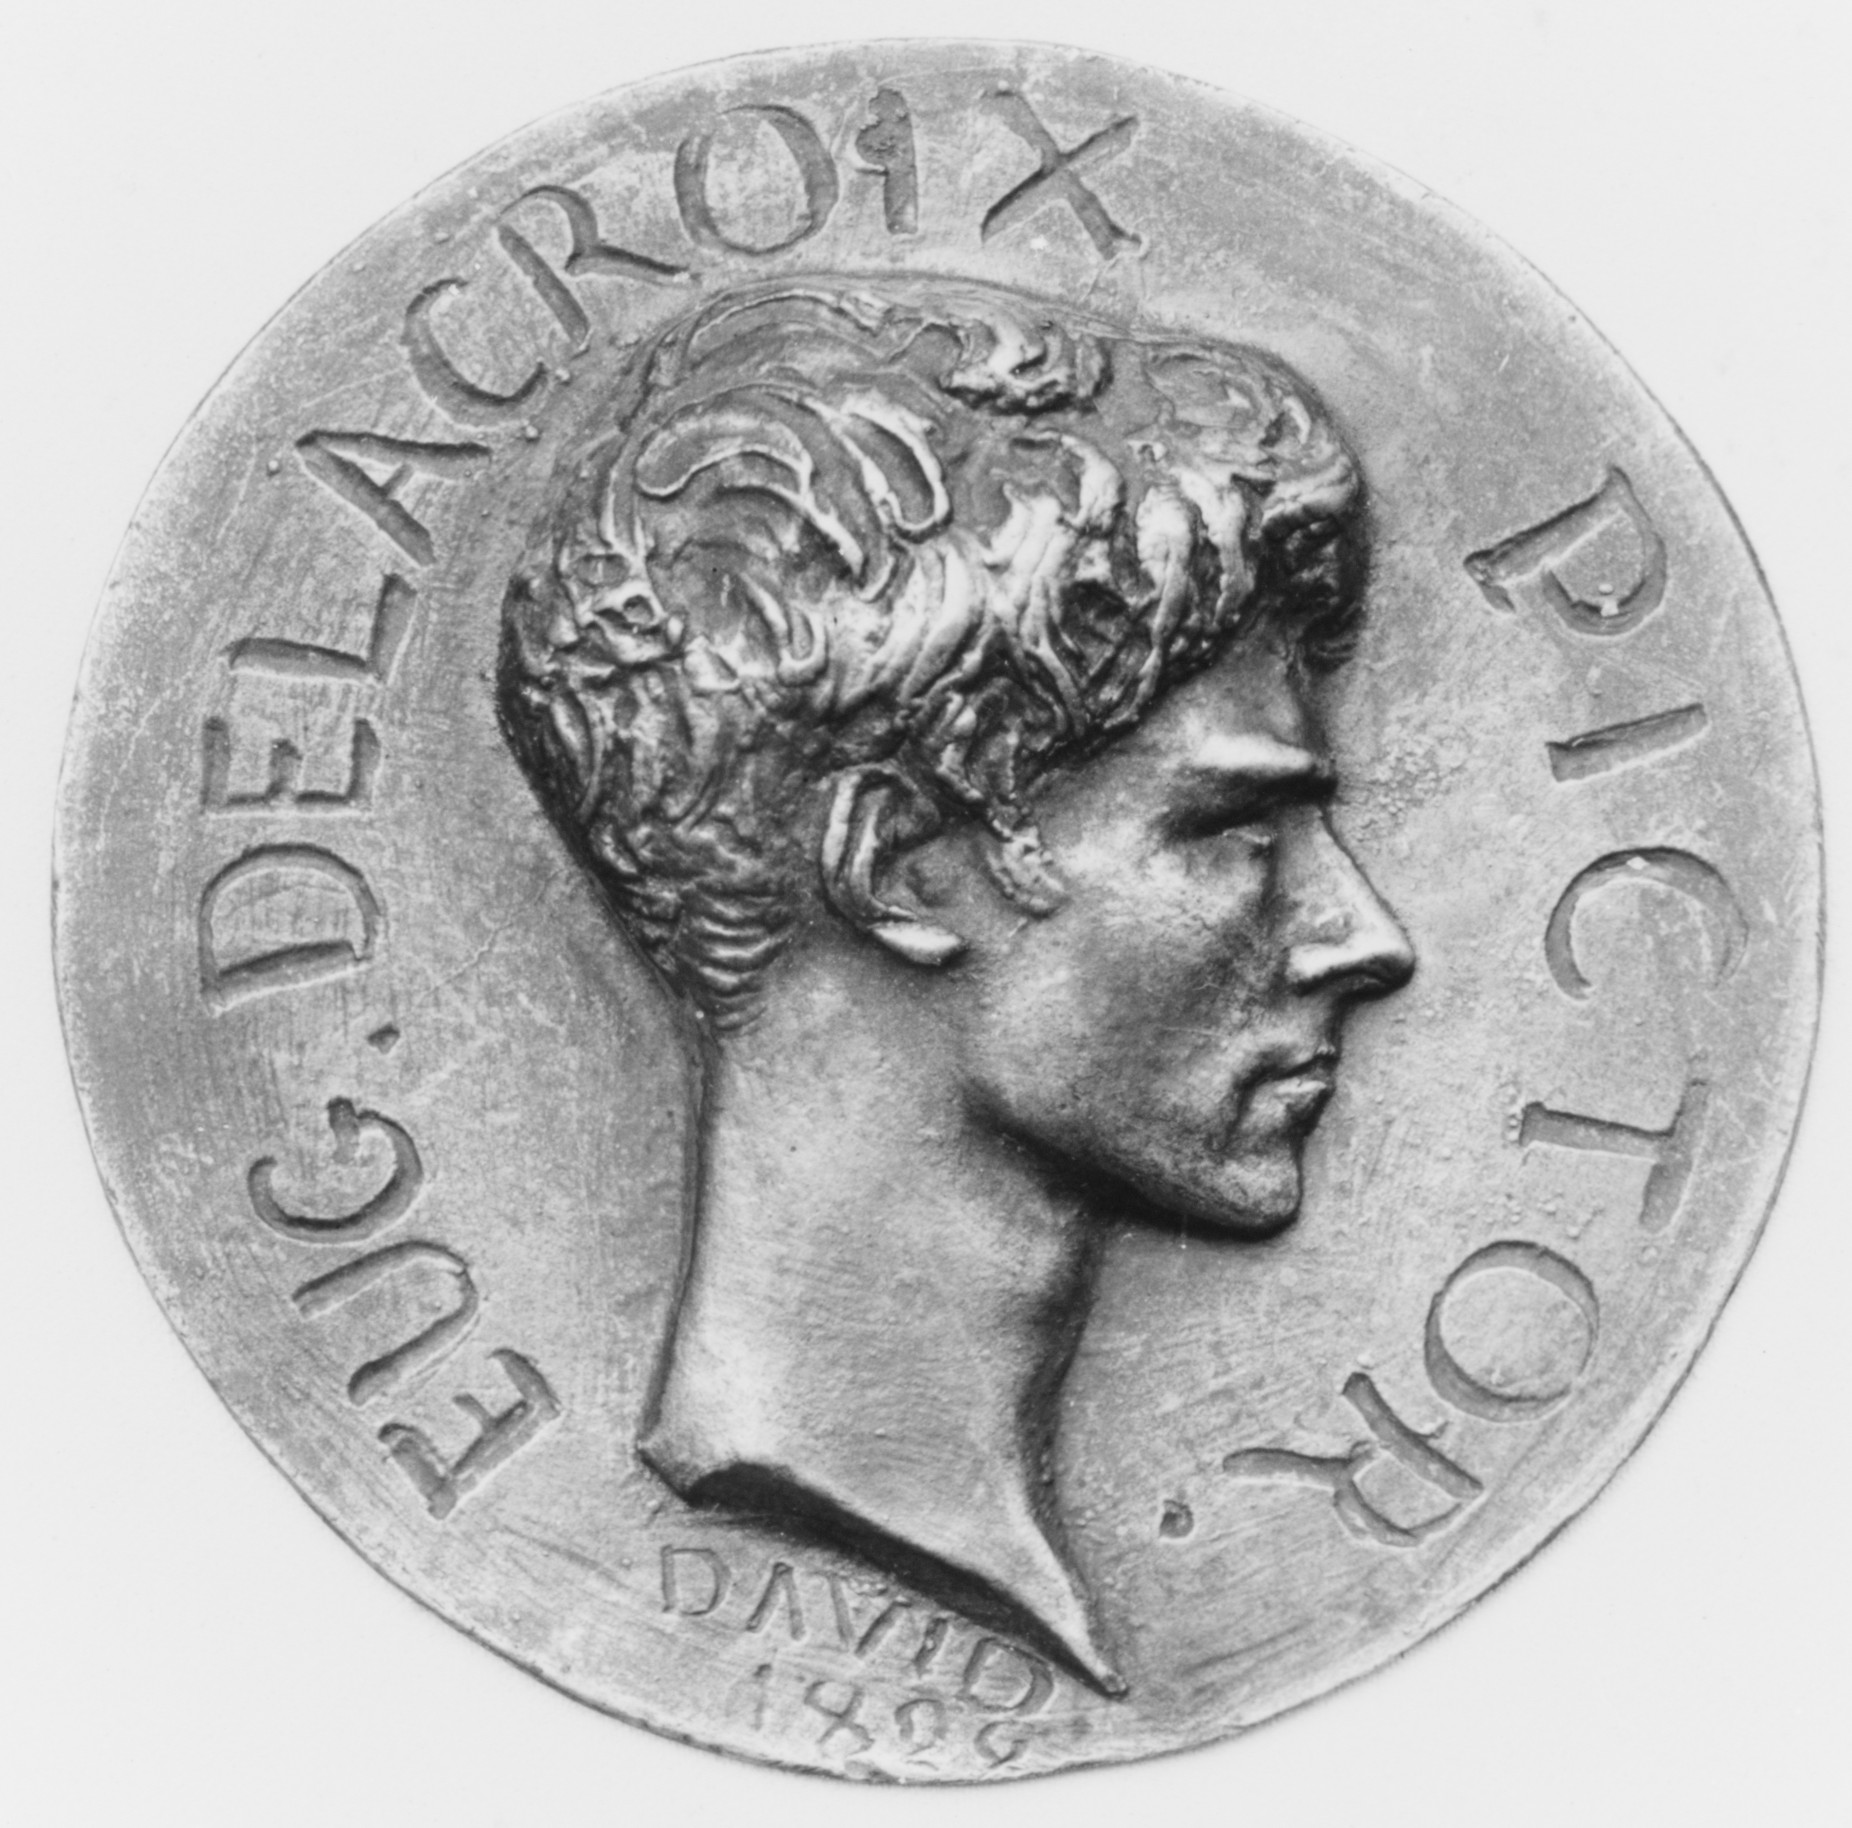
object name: medallion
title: Ferdinand Victor Eugène Delacroix (1798–1863)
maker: pierre jean david d'angers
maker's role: artist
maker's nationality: french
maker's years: 1788-1856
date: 1828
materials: bronze, patina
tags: men,profiles